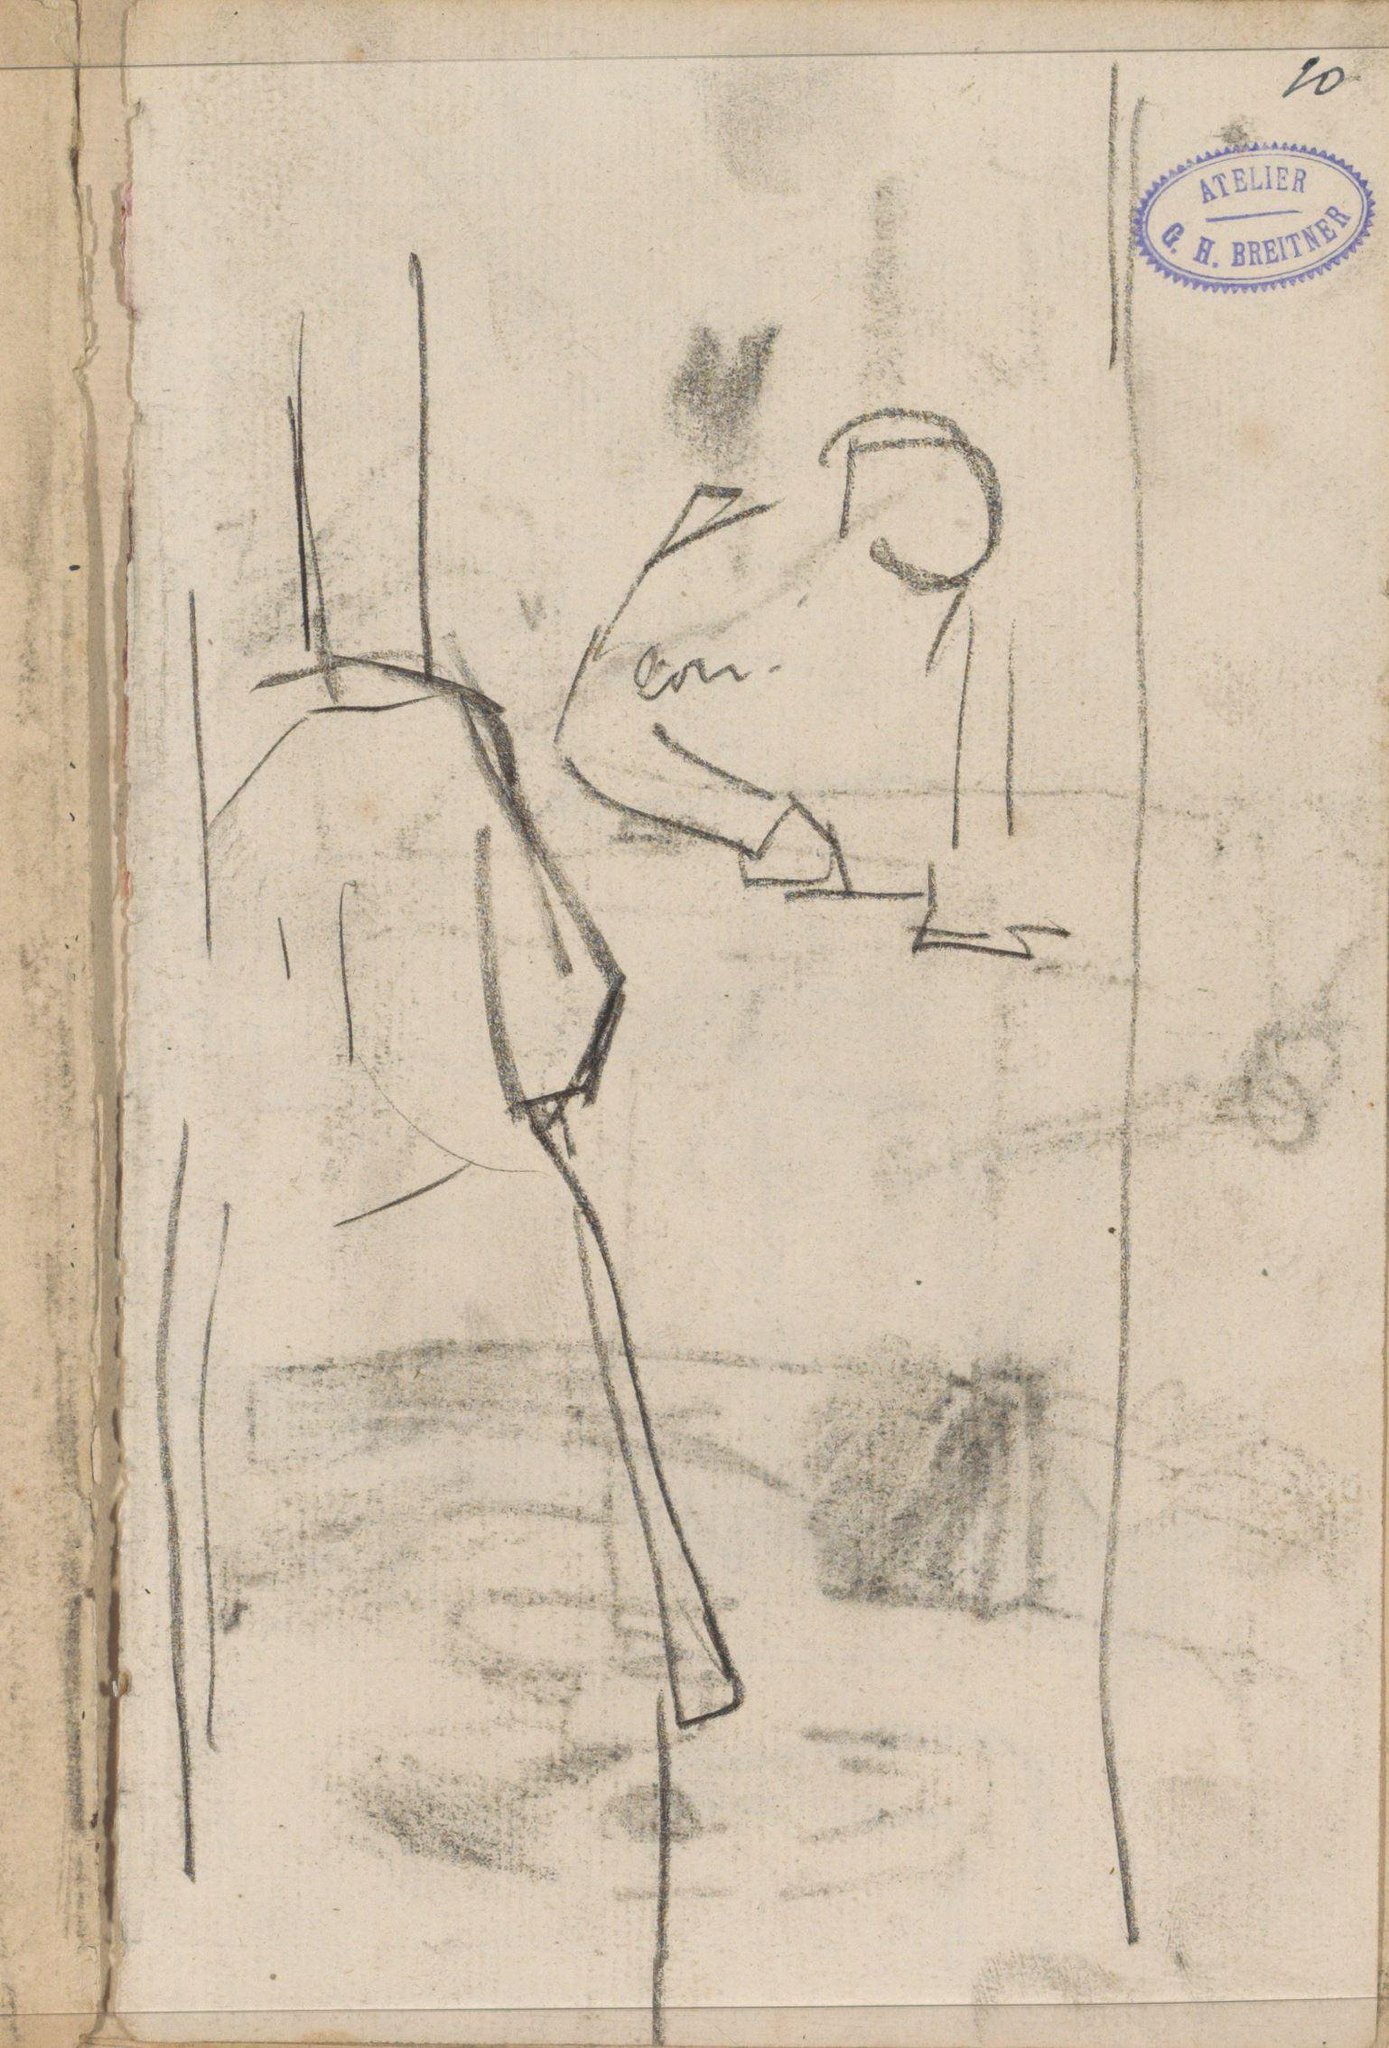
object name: sketchbook leaf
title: Staande vrouw en een zittende figuur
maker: george hendrik breitner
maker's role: draughtsman, painter, print maker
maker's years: 1857-1923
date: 1886-1923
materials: chalk, paper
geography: amsterdam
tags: sitting figure, standing figure - aa - female human figure (+ back view)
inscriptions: : ‘zon’, workshop stamp: Lugt 291d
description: Pagina 10 uit een schetsboek met 19 bladen en 9 losse tekeningen.